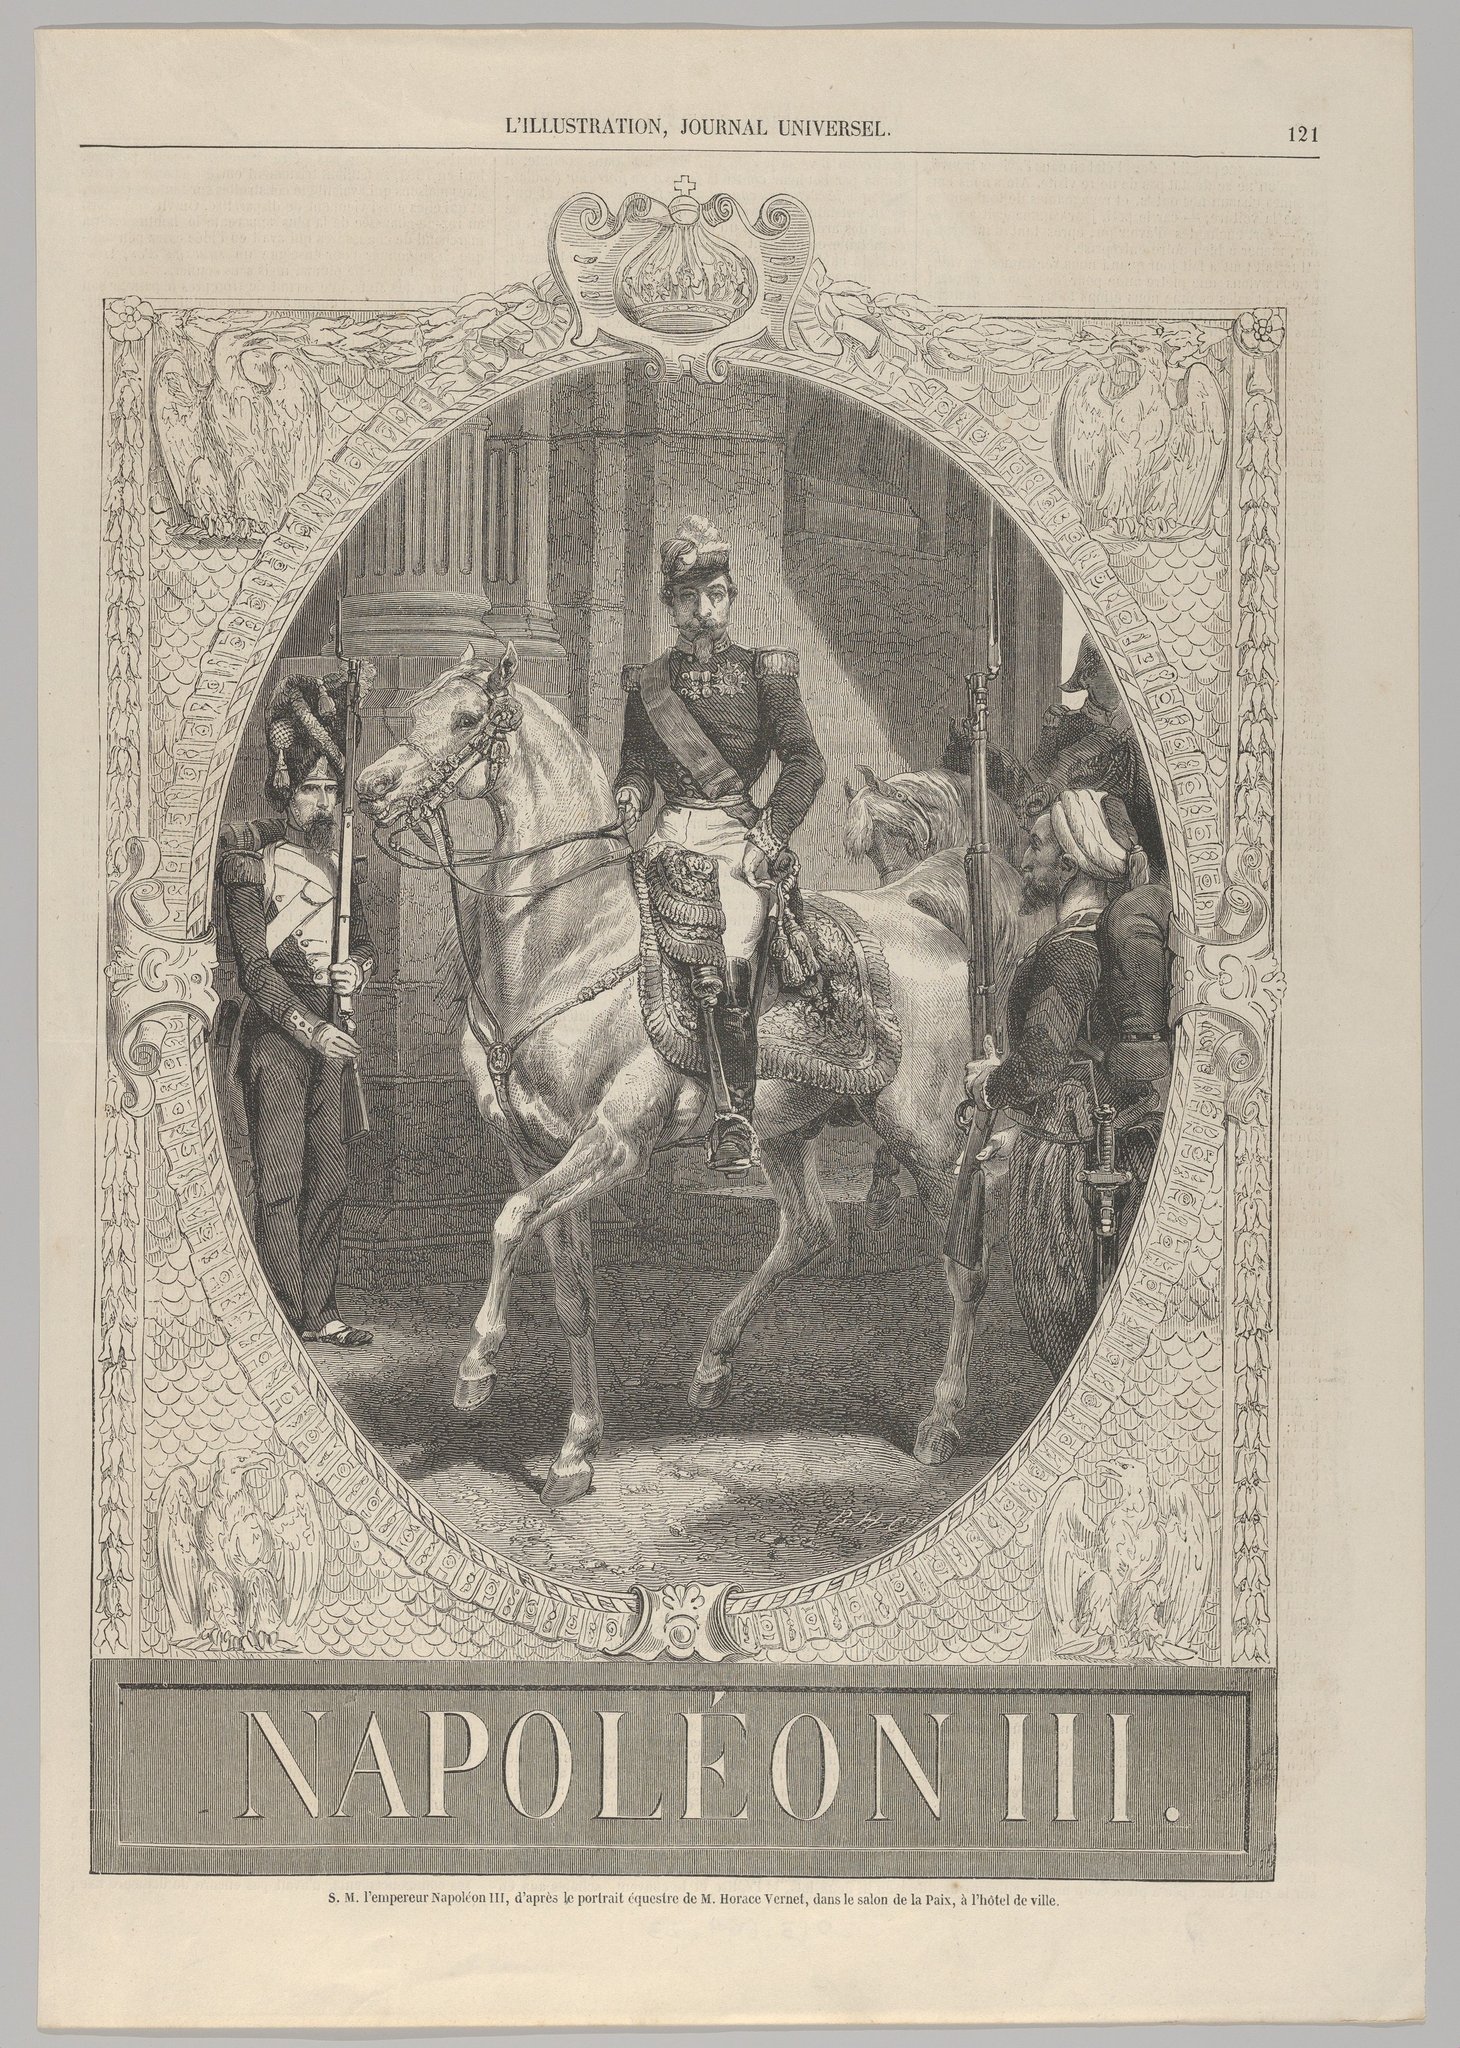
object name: print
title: Napoléon III, from "L'Illustration"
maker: anonymous, french, 19th century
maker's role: engraver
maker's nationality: french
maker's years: 1800-1900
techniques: engraving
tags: napoleon iii,horses